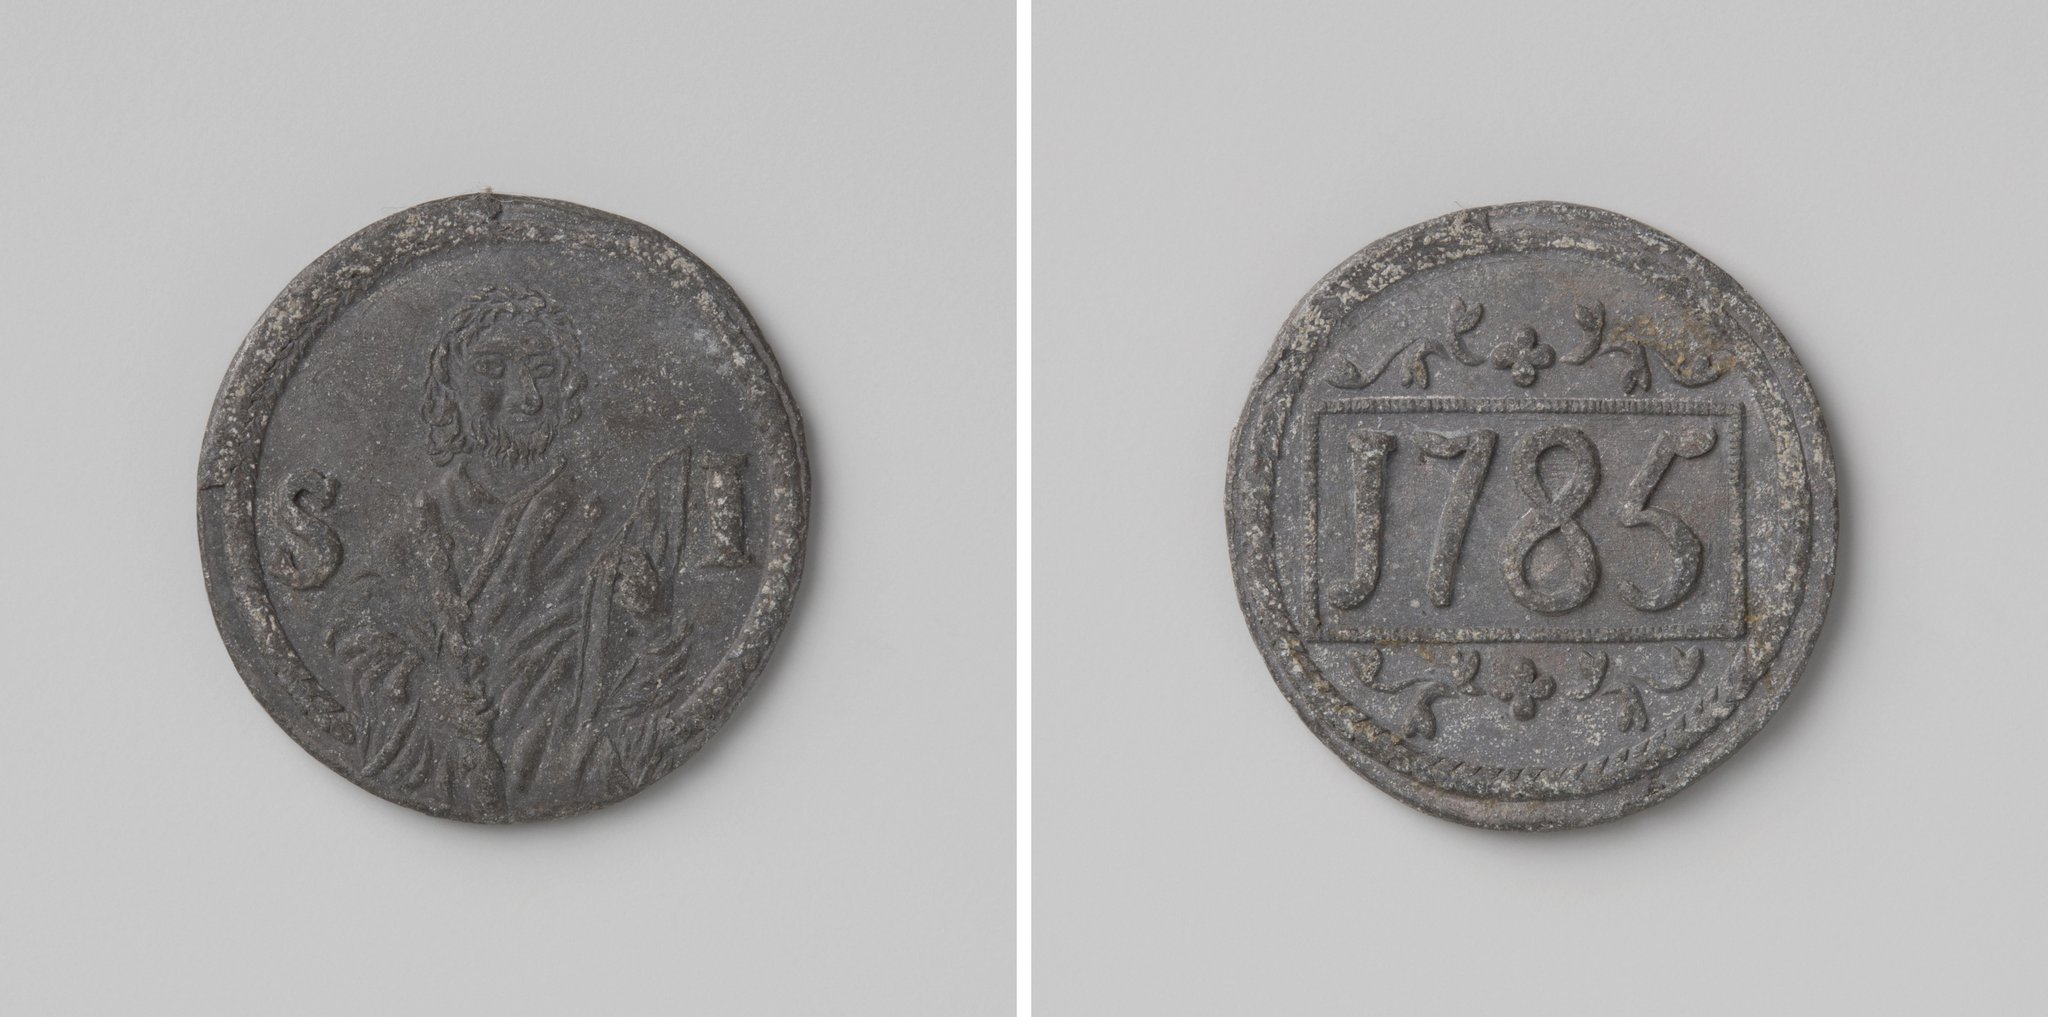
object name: devotional medal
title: Sint Johannes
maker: Anonymous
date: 1785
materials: lead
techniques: casting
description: Loden penning. Voorzijde: Sint Johannes met baard en face, houdt stok in rechter- en voorwerp in linkerhand tussen letters S en I binnen bladerkrans. Keerzijde: jaartal in versierd compartiment binnen bladerkrans